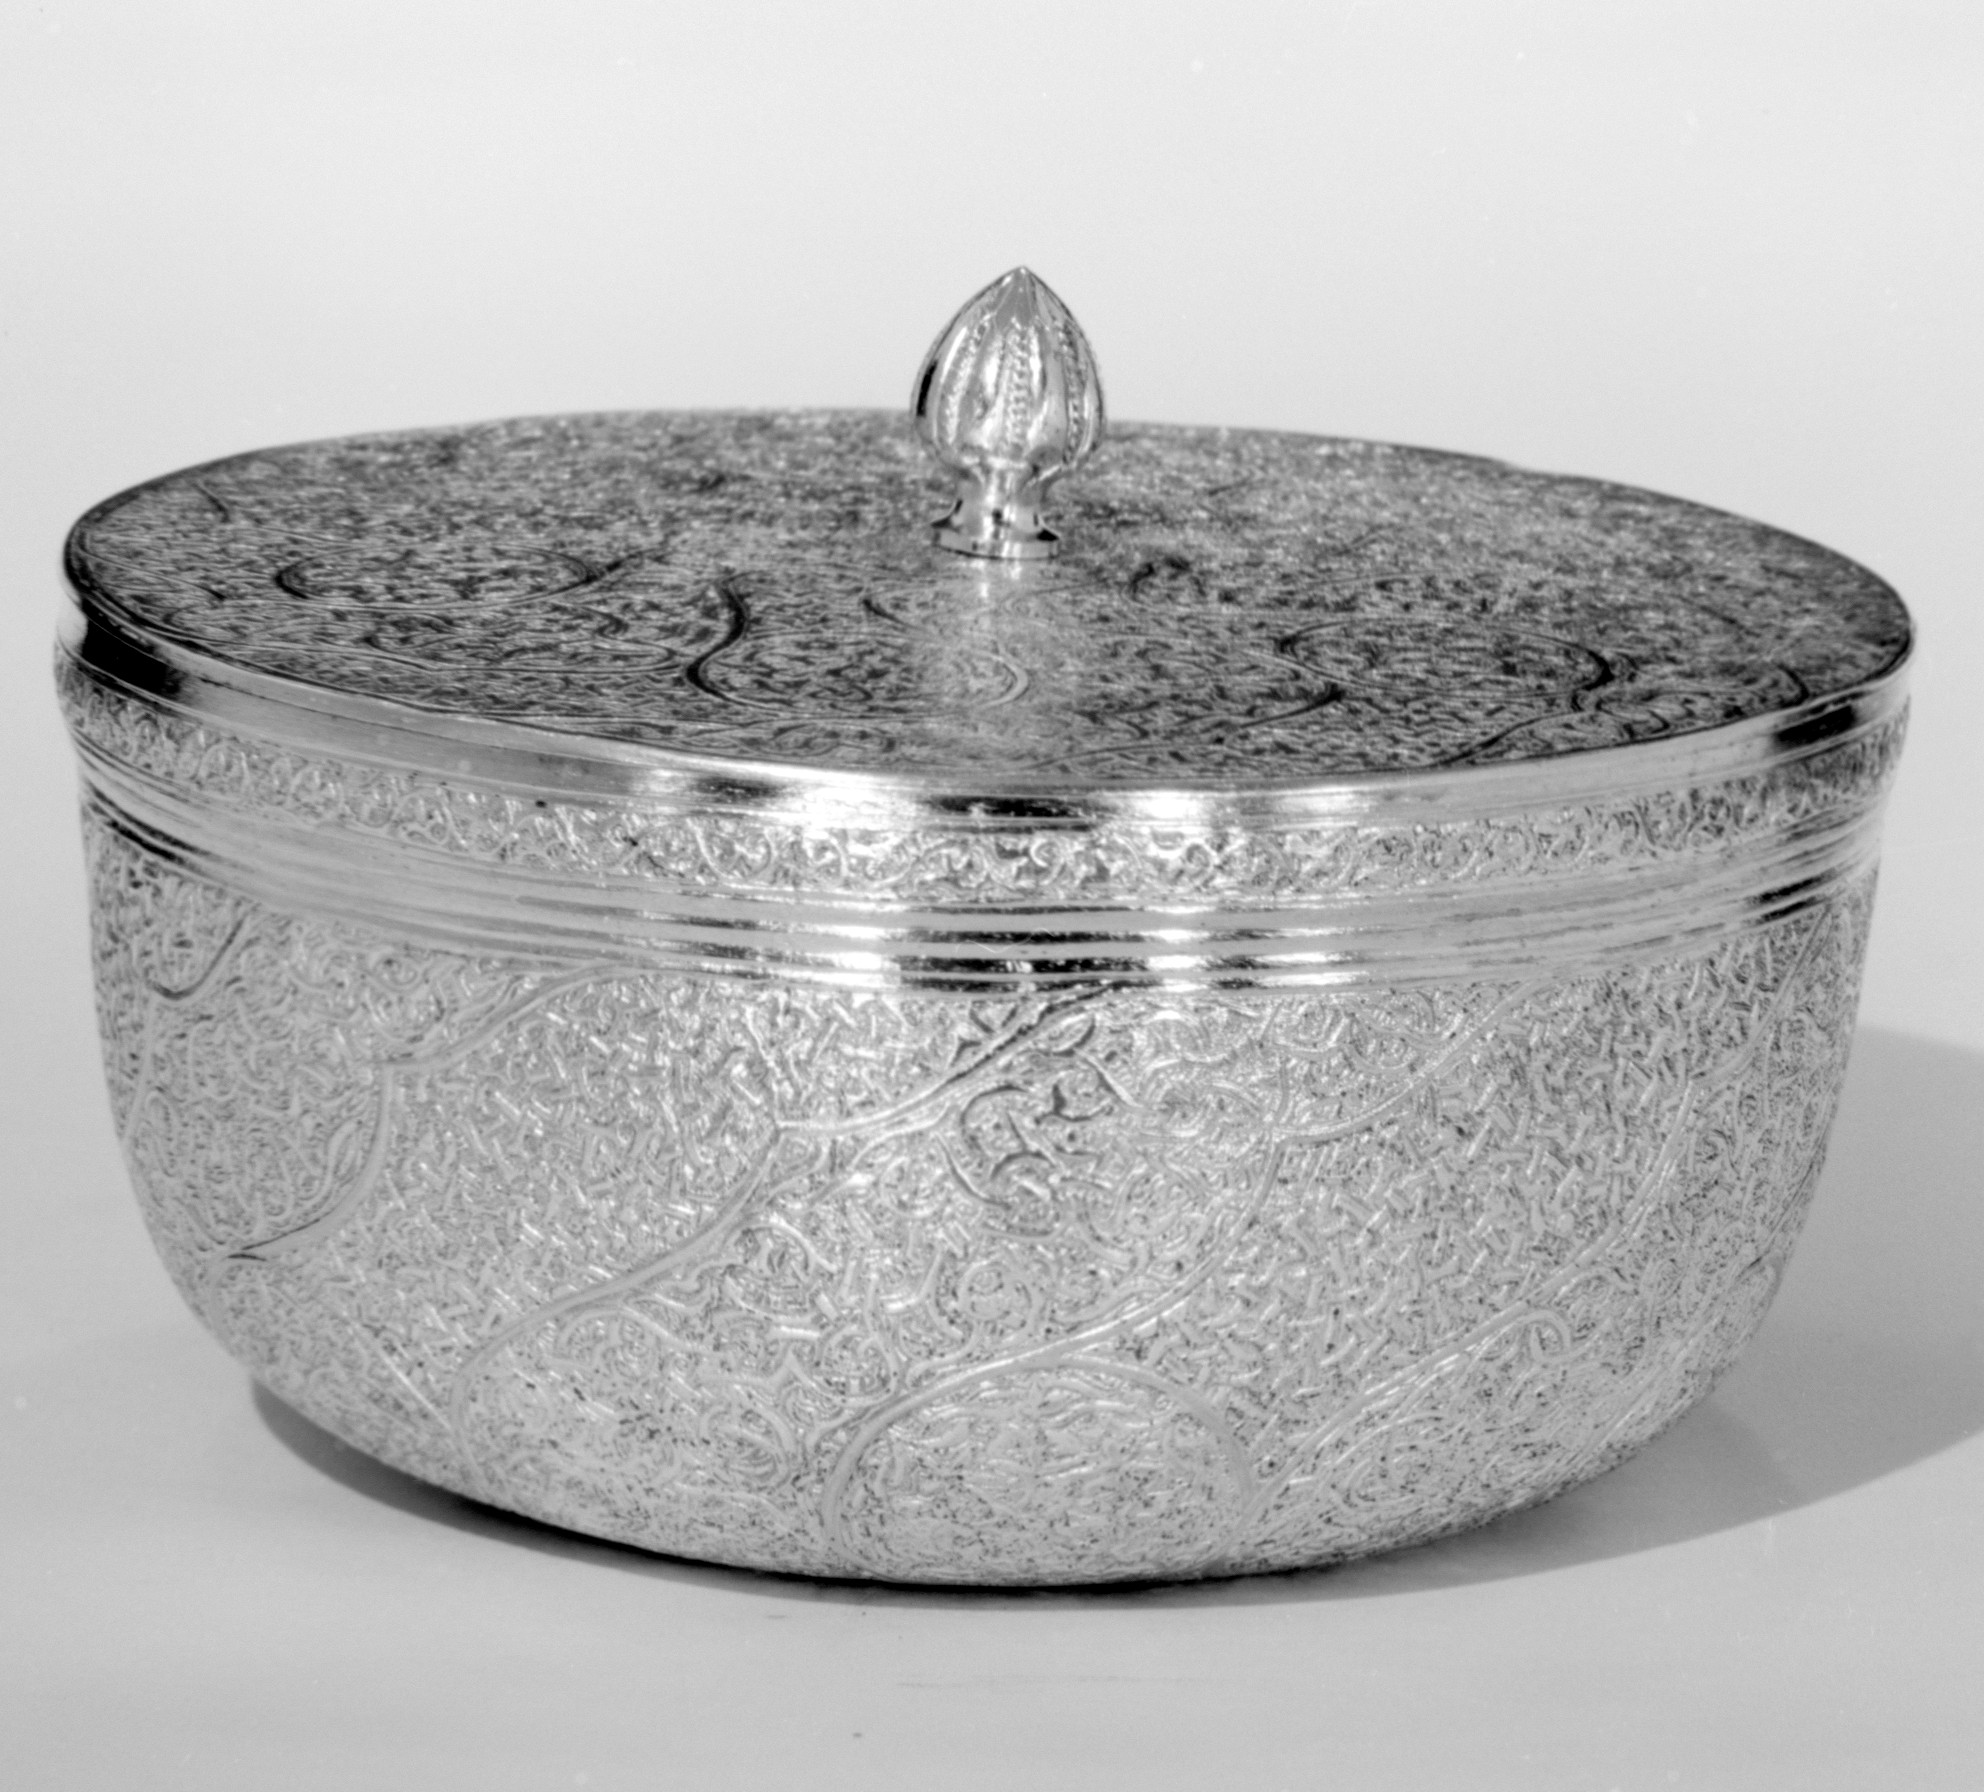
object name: bowl with cover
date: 1801-1900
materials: brass